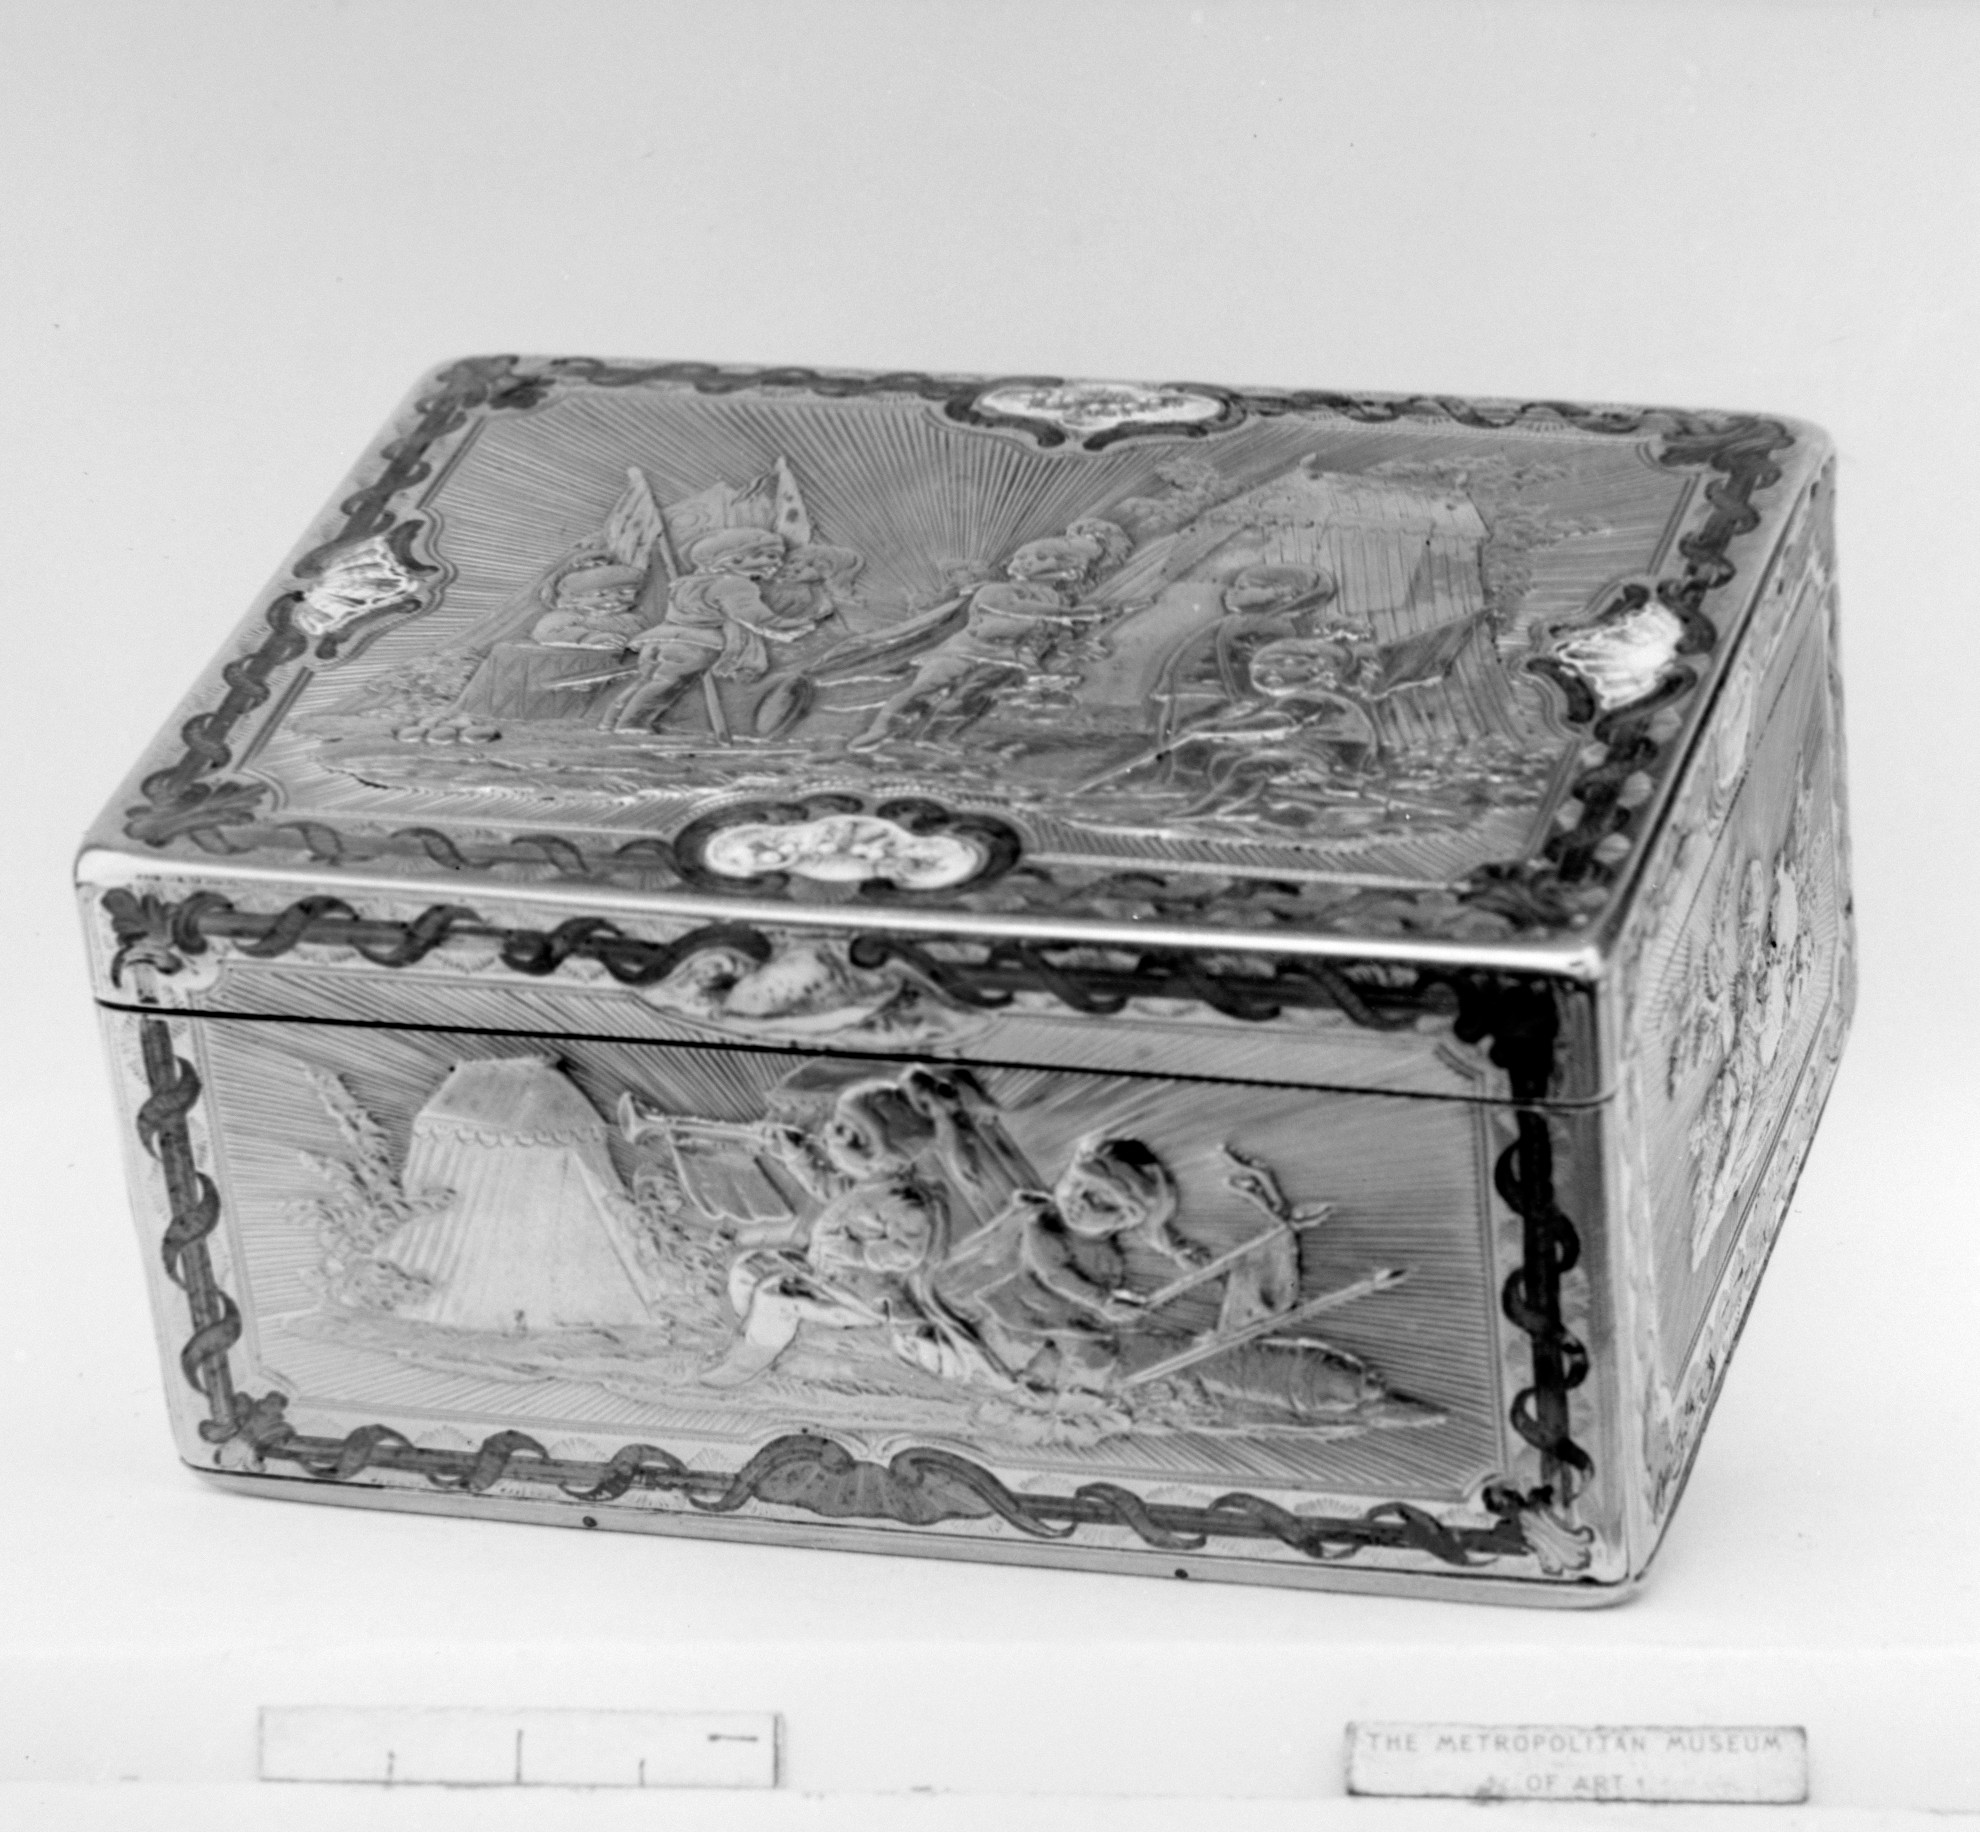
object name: snuffbox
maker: jean georges (or george)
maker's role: maker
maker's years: 1665-1765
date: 1757-1758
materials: enamel, gold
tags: children,horns